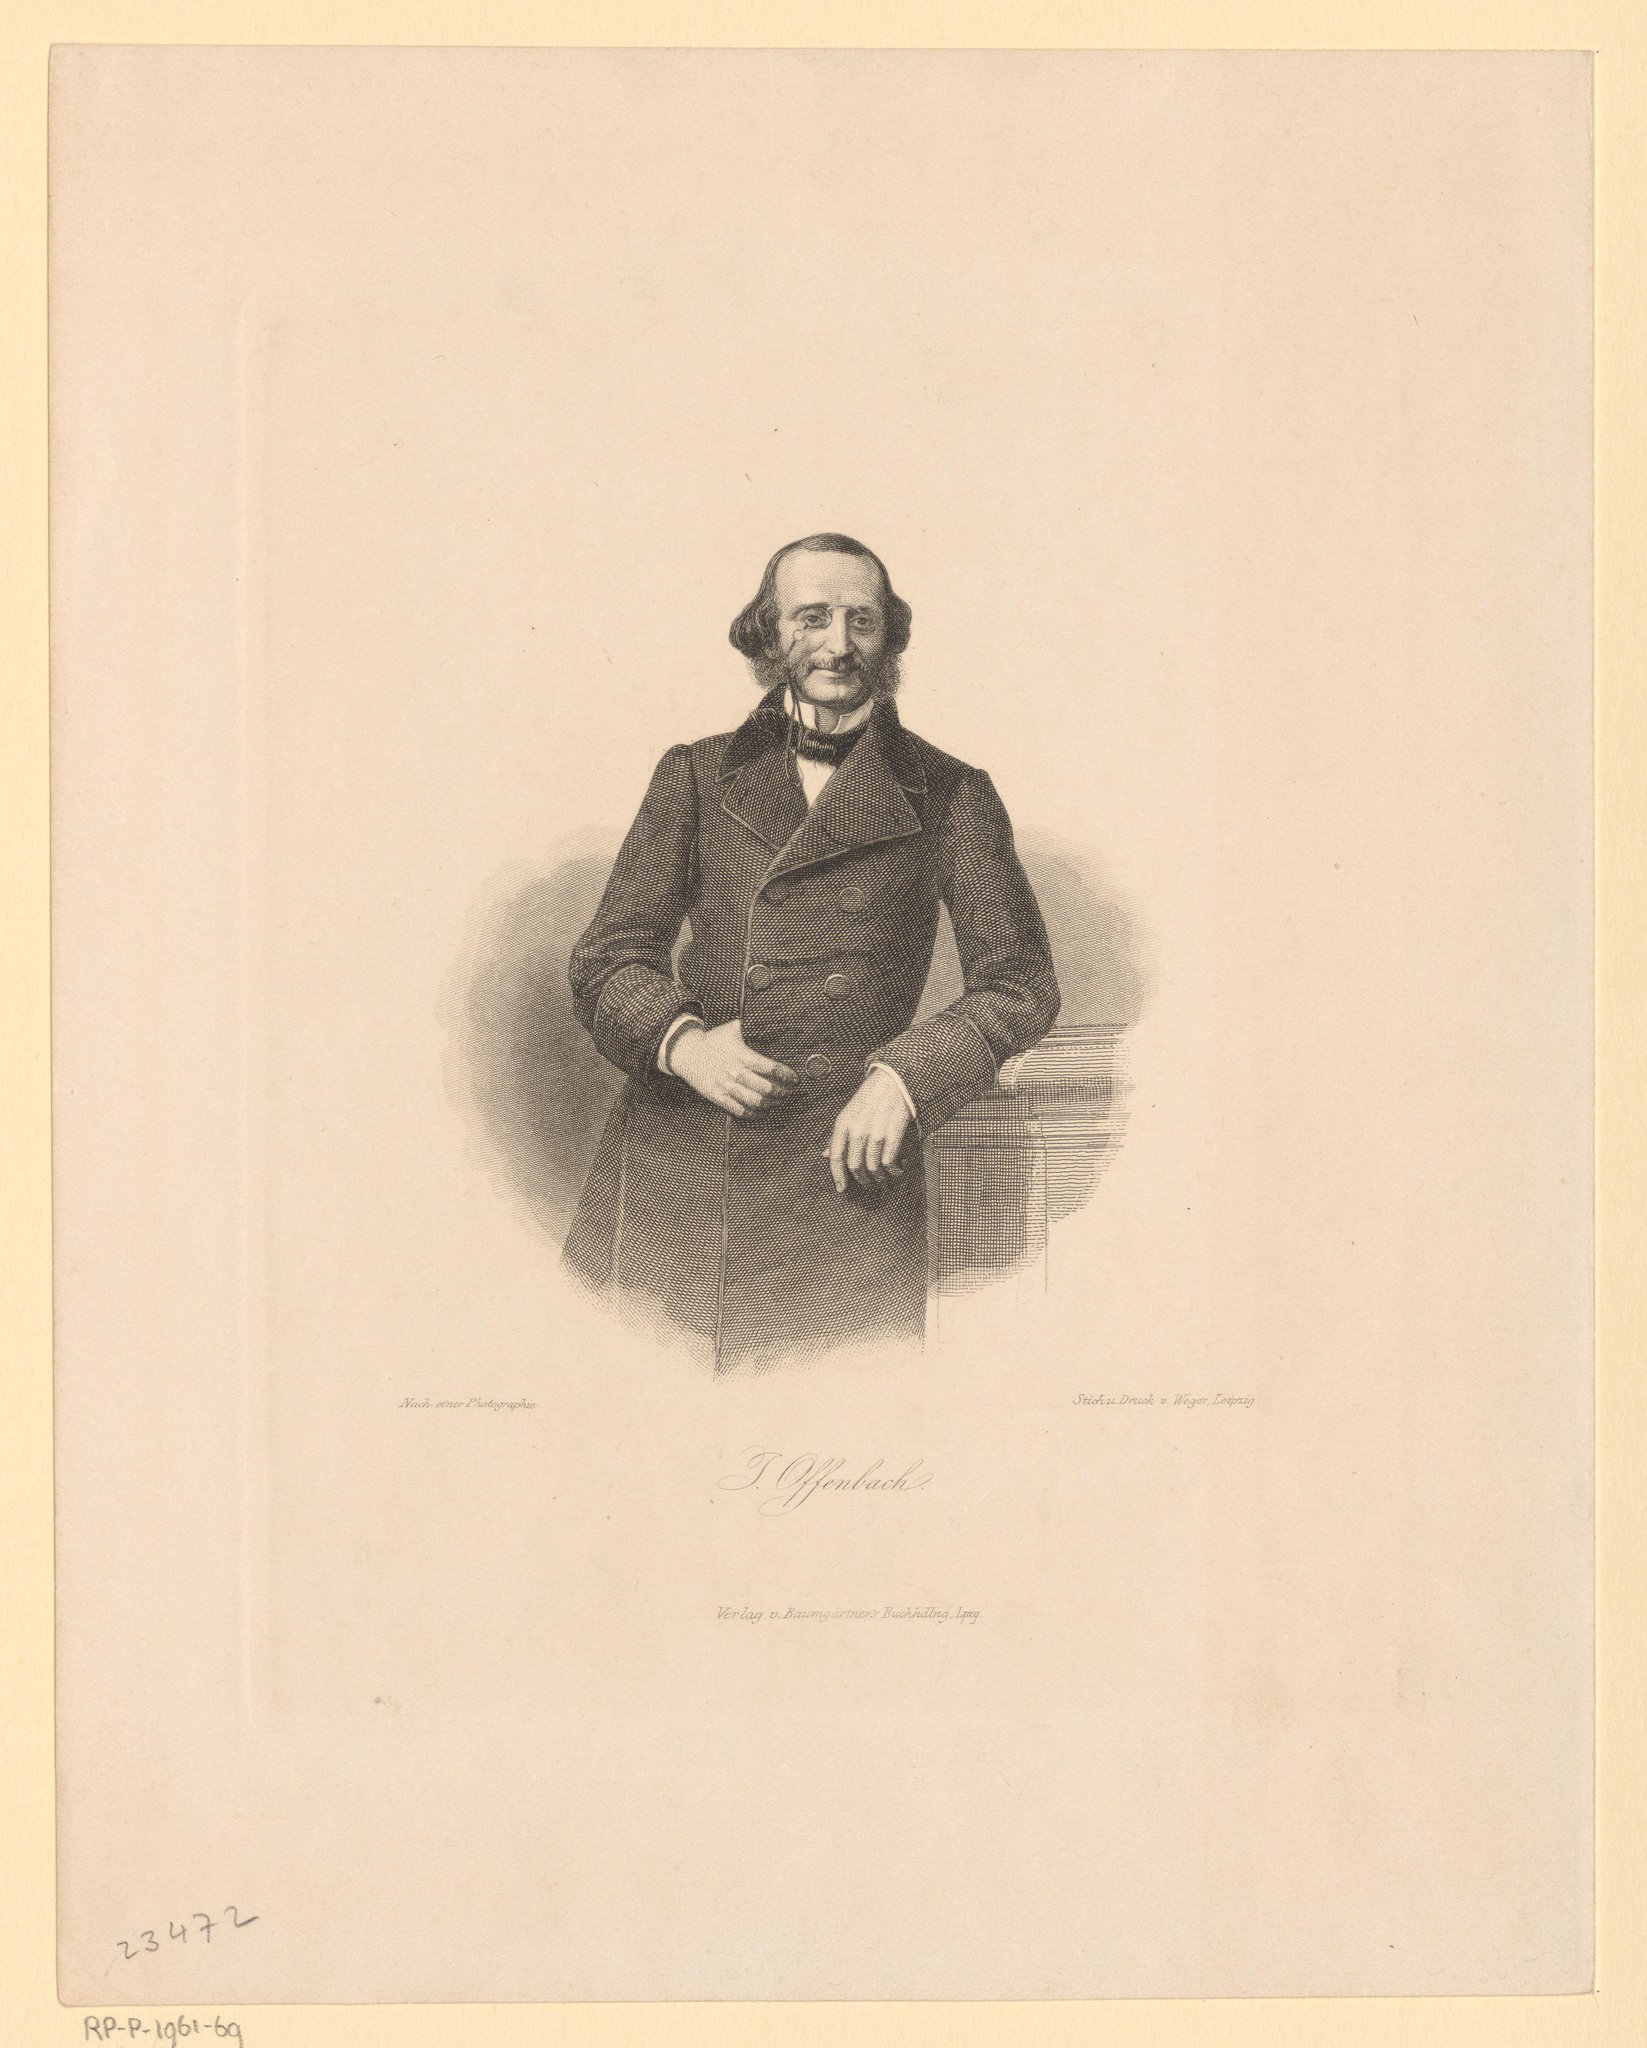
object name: print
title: Portret van Jacques Offenbach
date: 1840-1892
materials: paper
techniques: engraving, etching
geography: leipzig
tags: jacques offenbach, historical persons